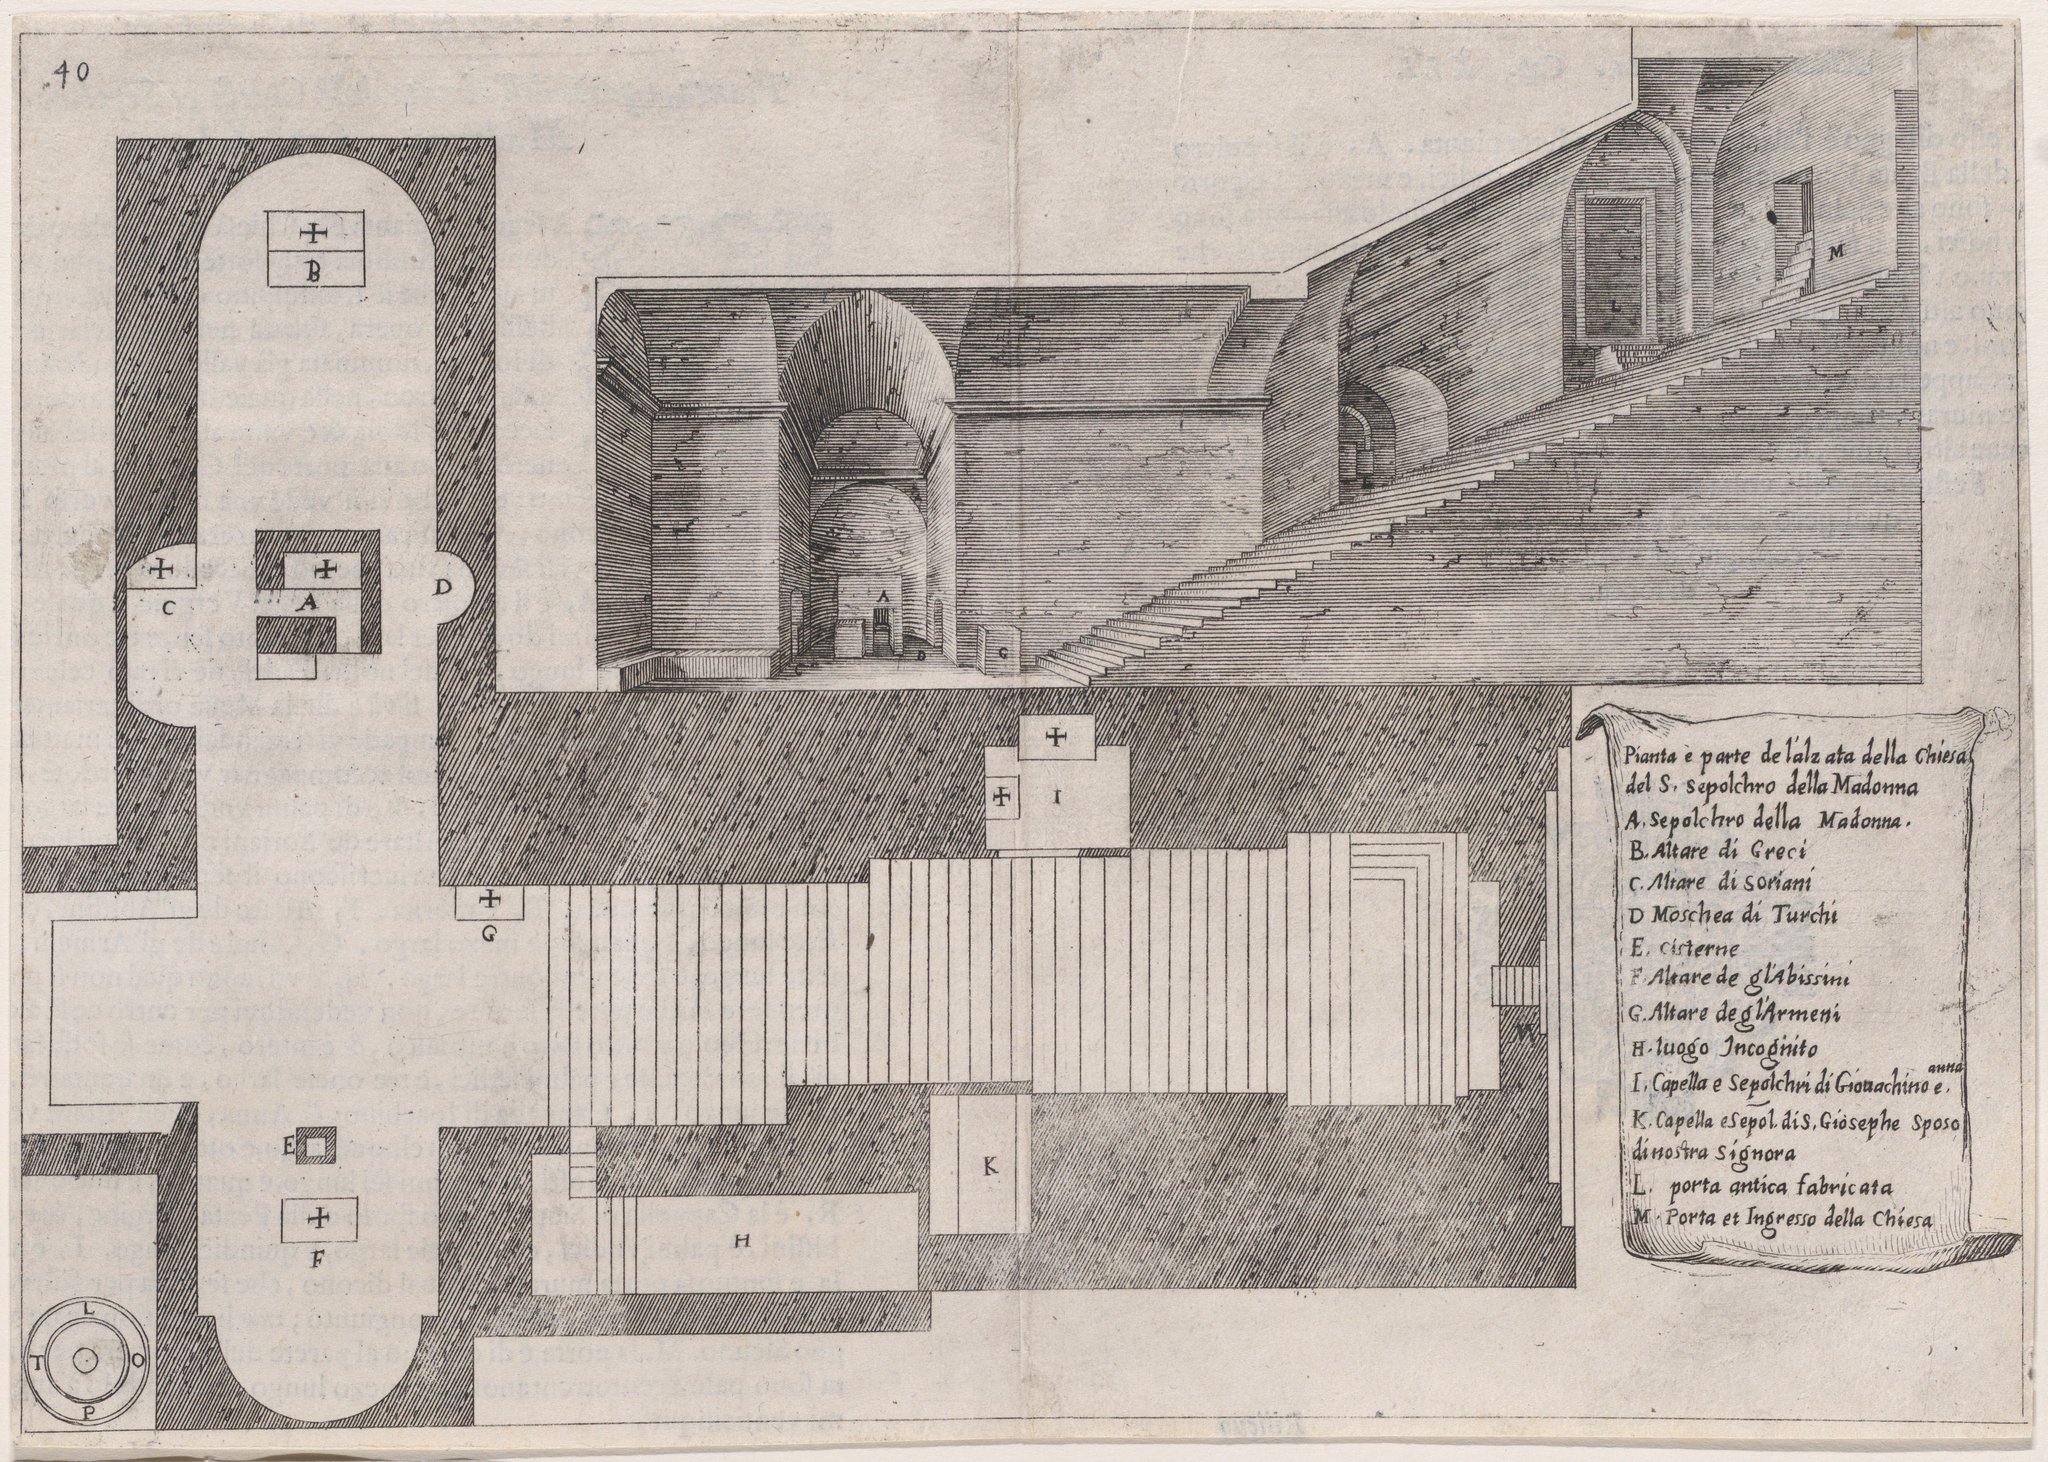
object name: print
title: Plate 33, from "Trattato delle Piante & Immagini de Sacri Edifizi di Terra Santa" (Treatise of the Plans & Images of the Sacred Buildings of the Holy Land)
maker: jacques callot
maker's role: artist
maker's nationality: french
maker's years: 1592-1635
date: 1620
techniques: engraving, etching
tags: architecture,buildings